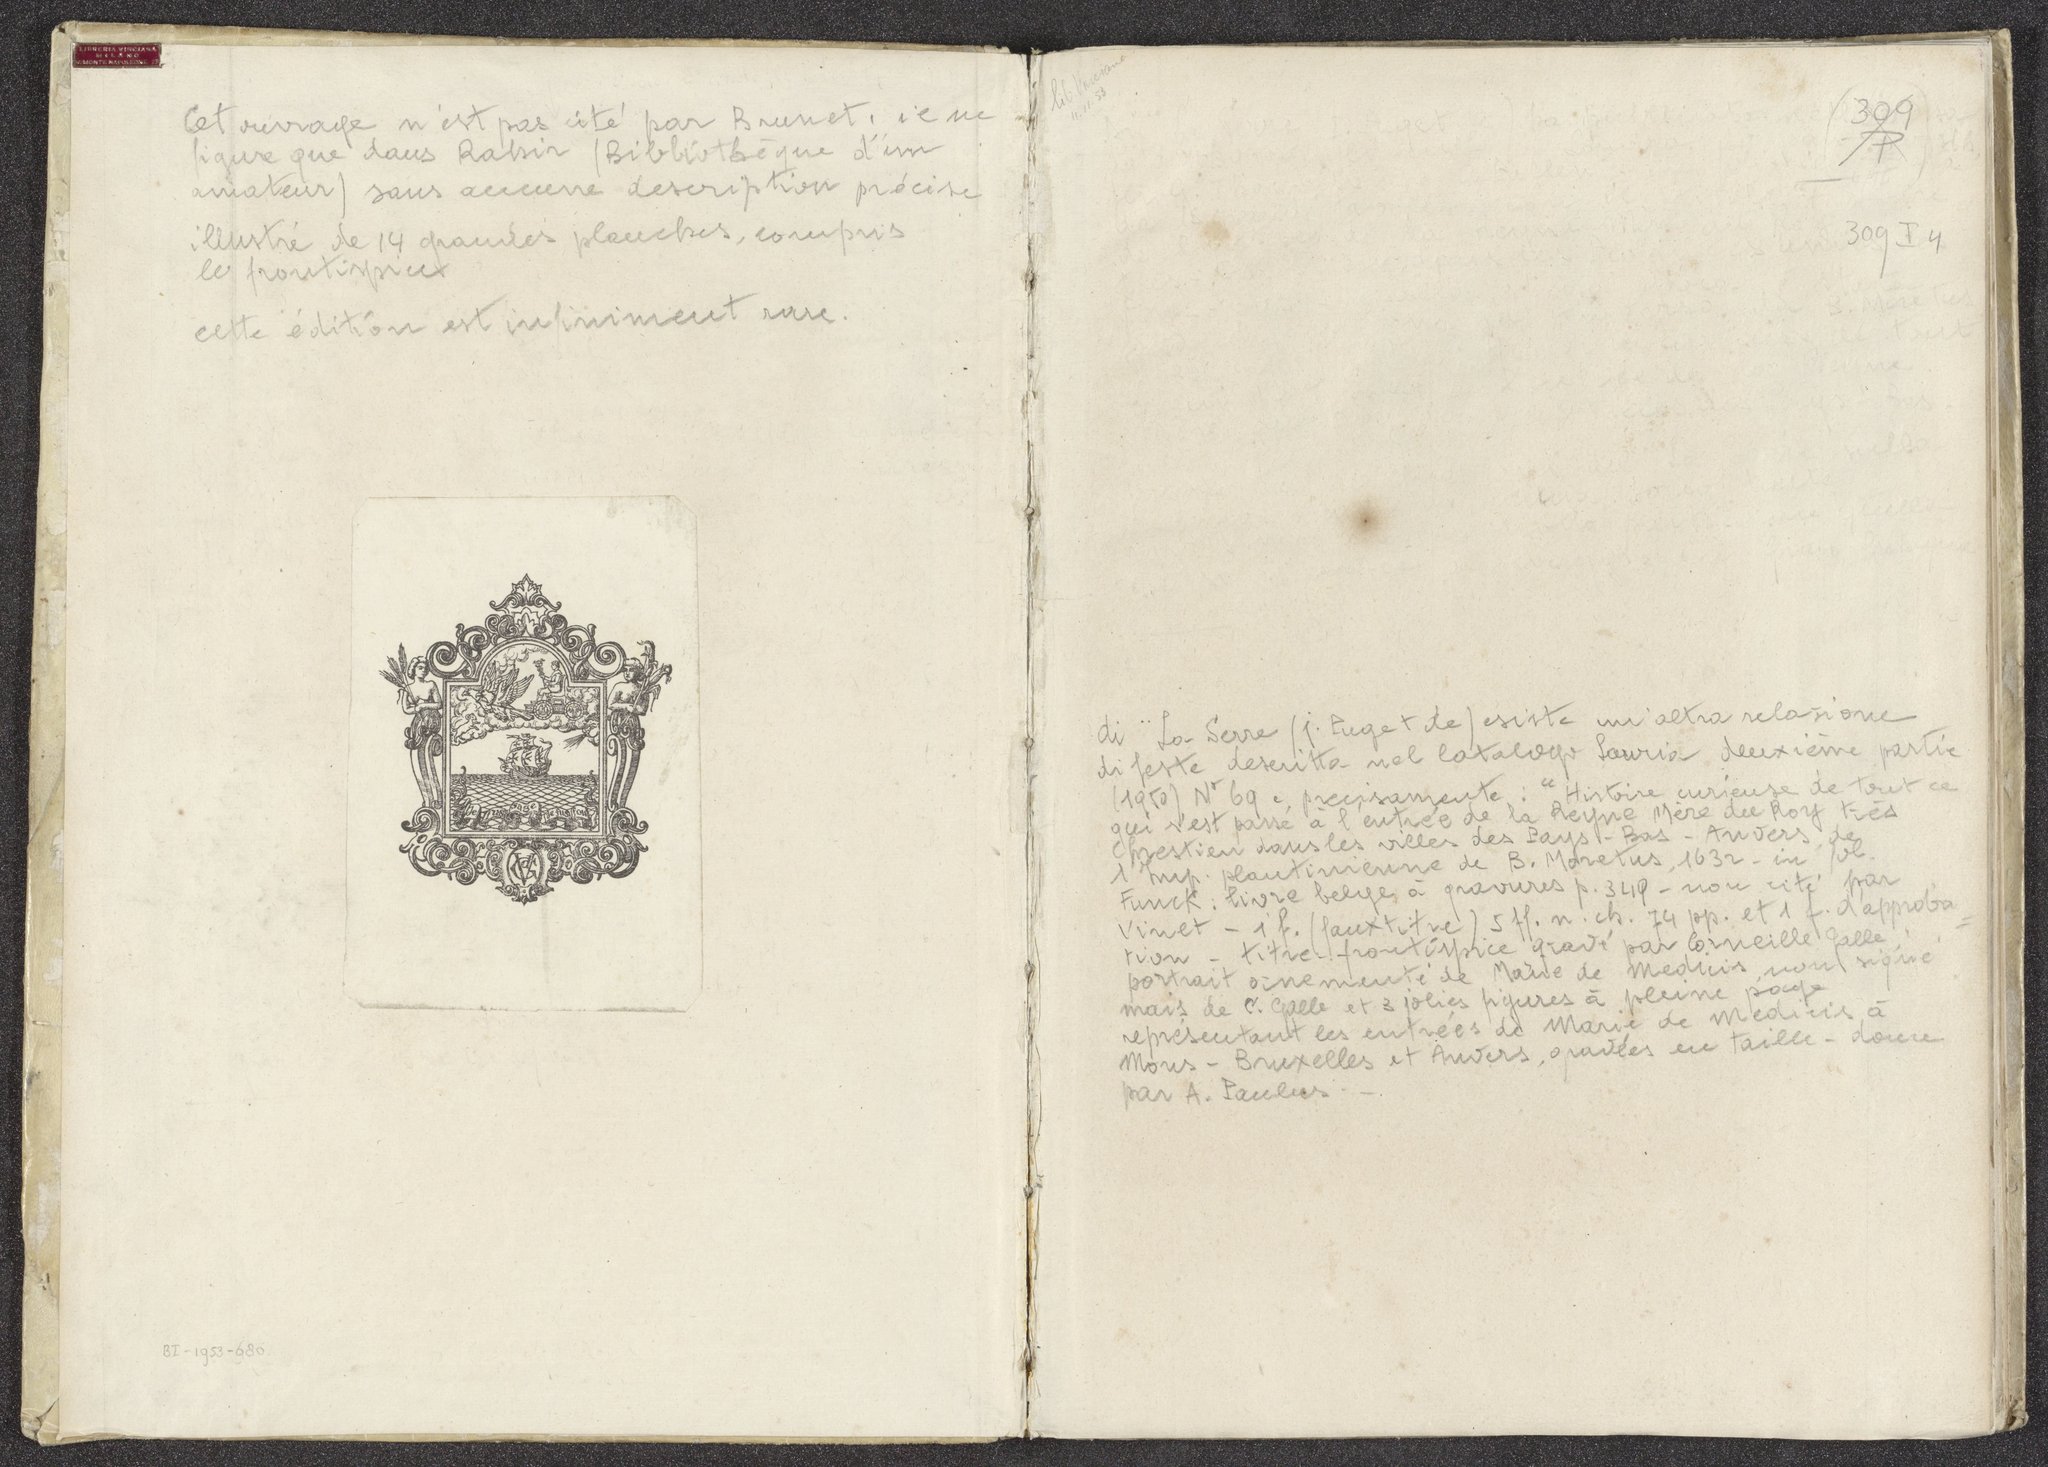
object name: bookplate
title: Histoire de l'entree de la reine mere du roy tres chrestien, dans la grande Bretagne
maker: alberto zanverdiani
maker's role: print maker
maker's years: 1894-1977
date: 1904-1977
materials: paper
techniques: woodcut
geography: venice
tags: (story of) mercury (hermes), ex-libris, ships (in general)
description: Cartouche met een schip en Mercurius in een strijdwagen getrokken door twee adelaars. Daarbij een banderol met het motto: Je fus sage je fus fou. Het geheel in een ornamentele rand met links een man met drie korenhalmen en rechts een man met twee maïsstengels. Onderaan het monogram VdG. De ex-libris is geplakt in een boek over de ontvangst van de Franse koning-moeder Maria de' Medici aan Engeland.